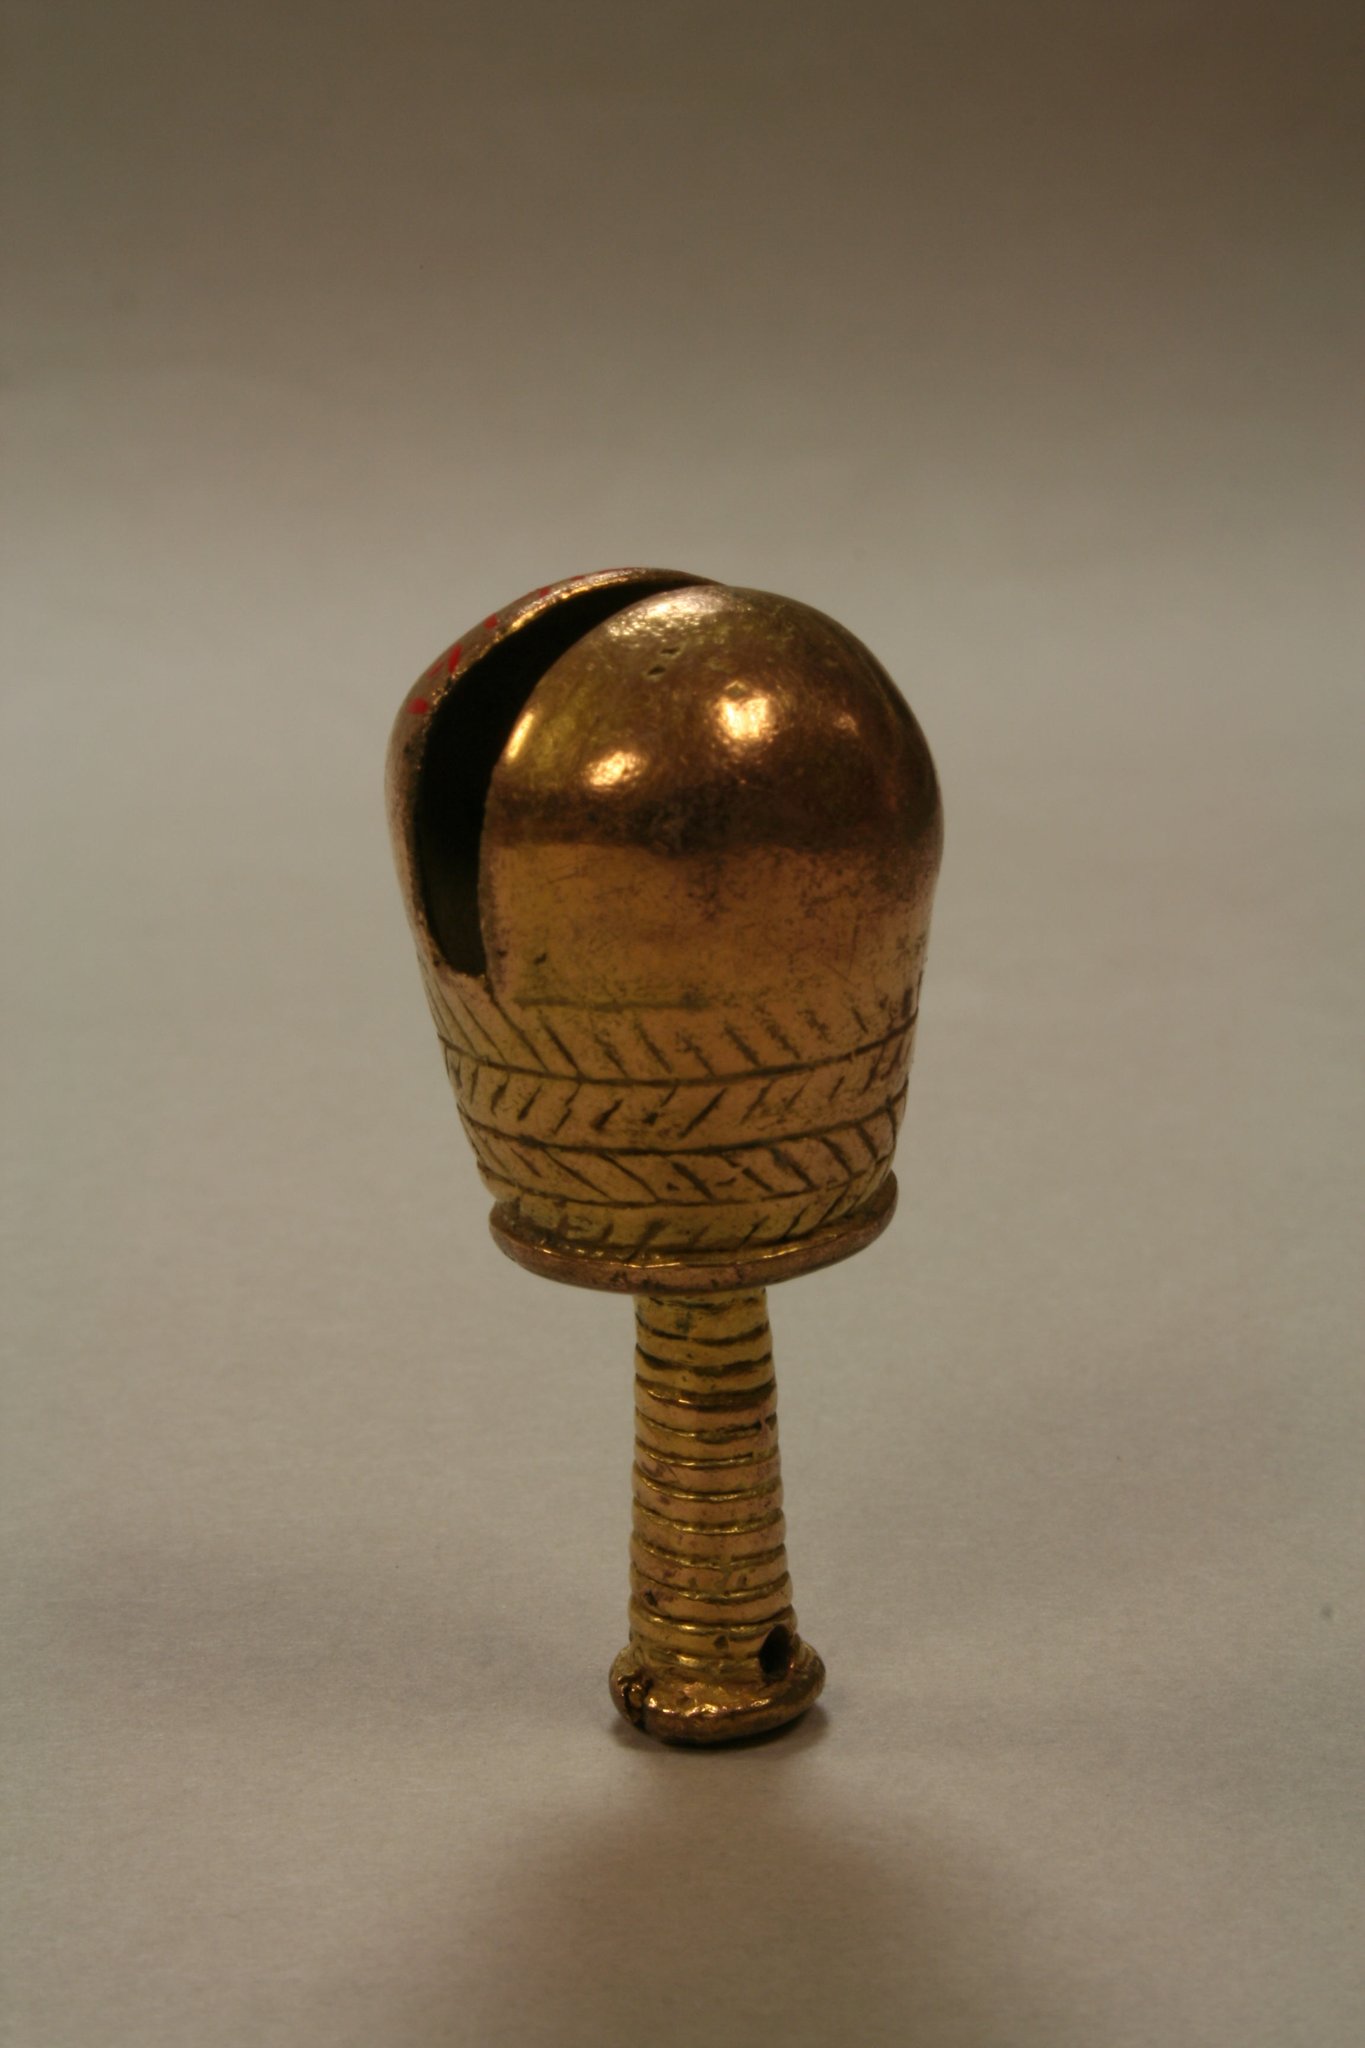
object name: bell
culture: greater coclé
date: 750-950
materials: alloy, gold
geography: panama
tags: musical instruments